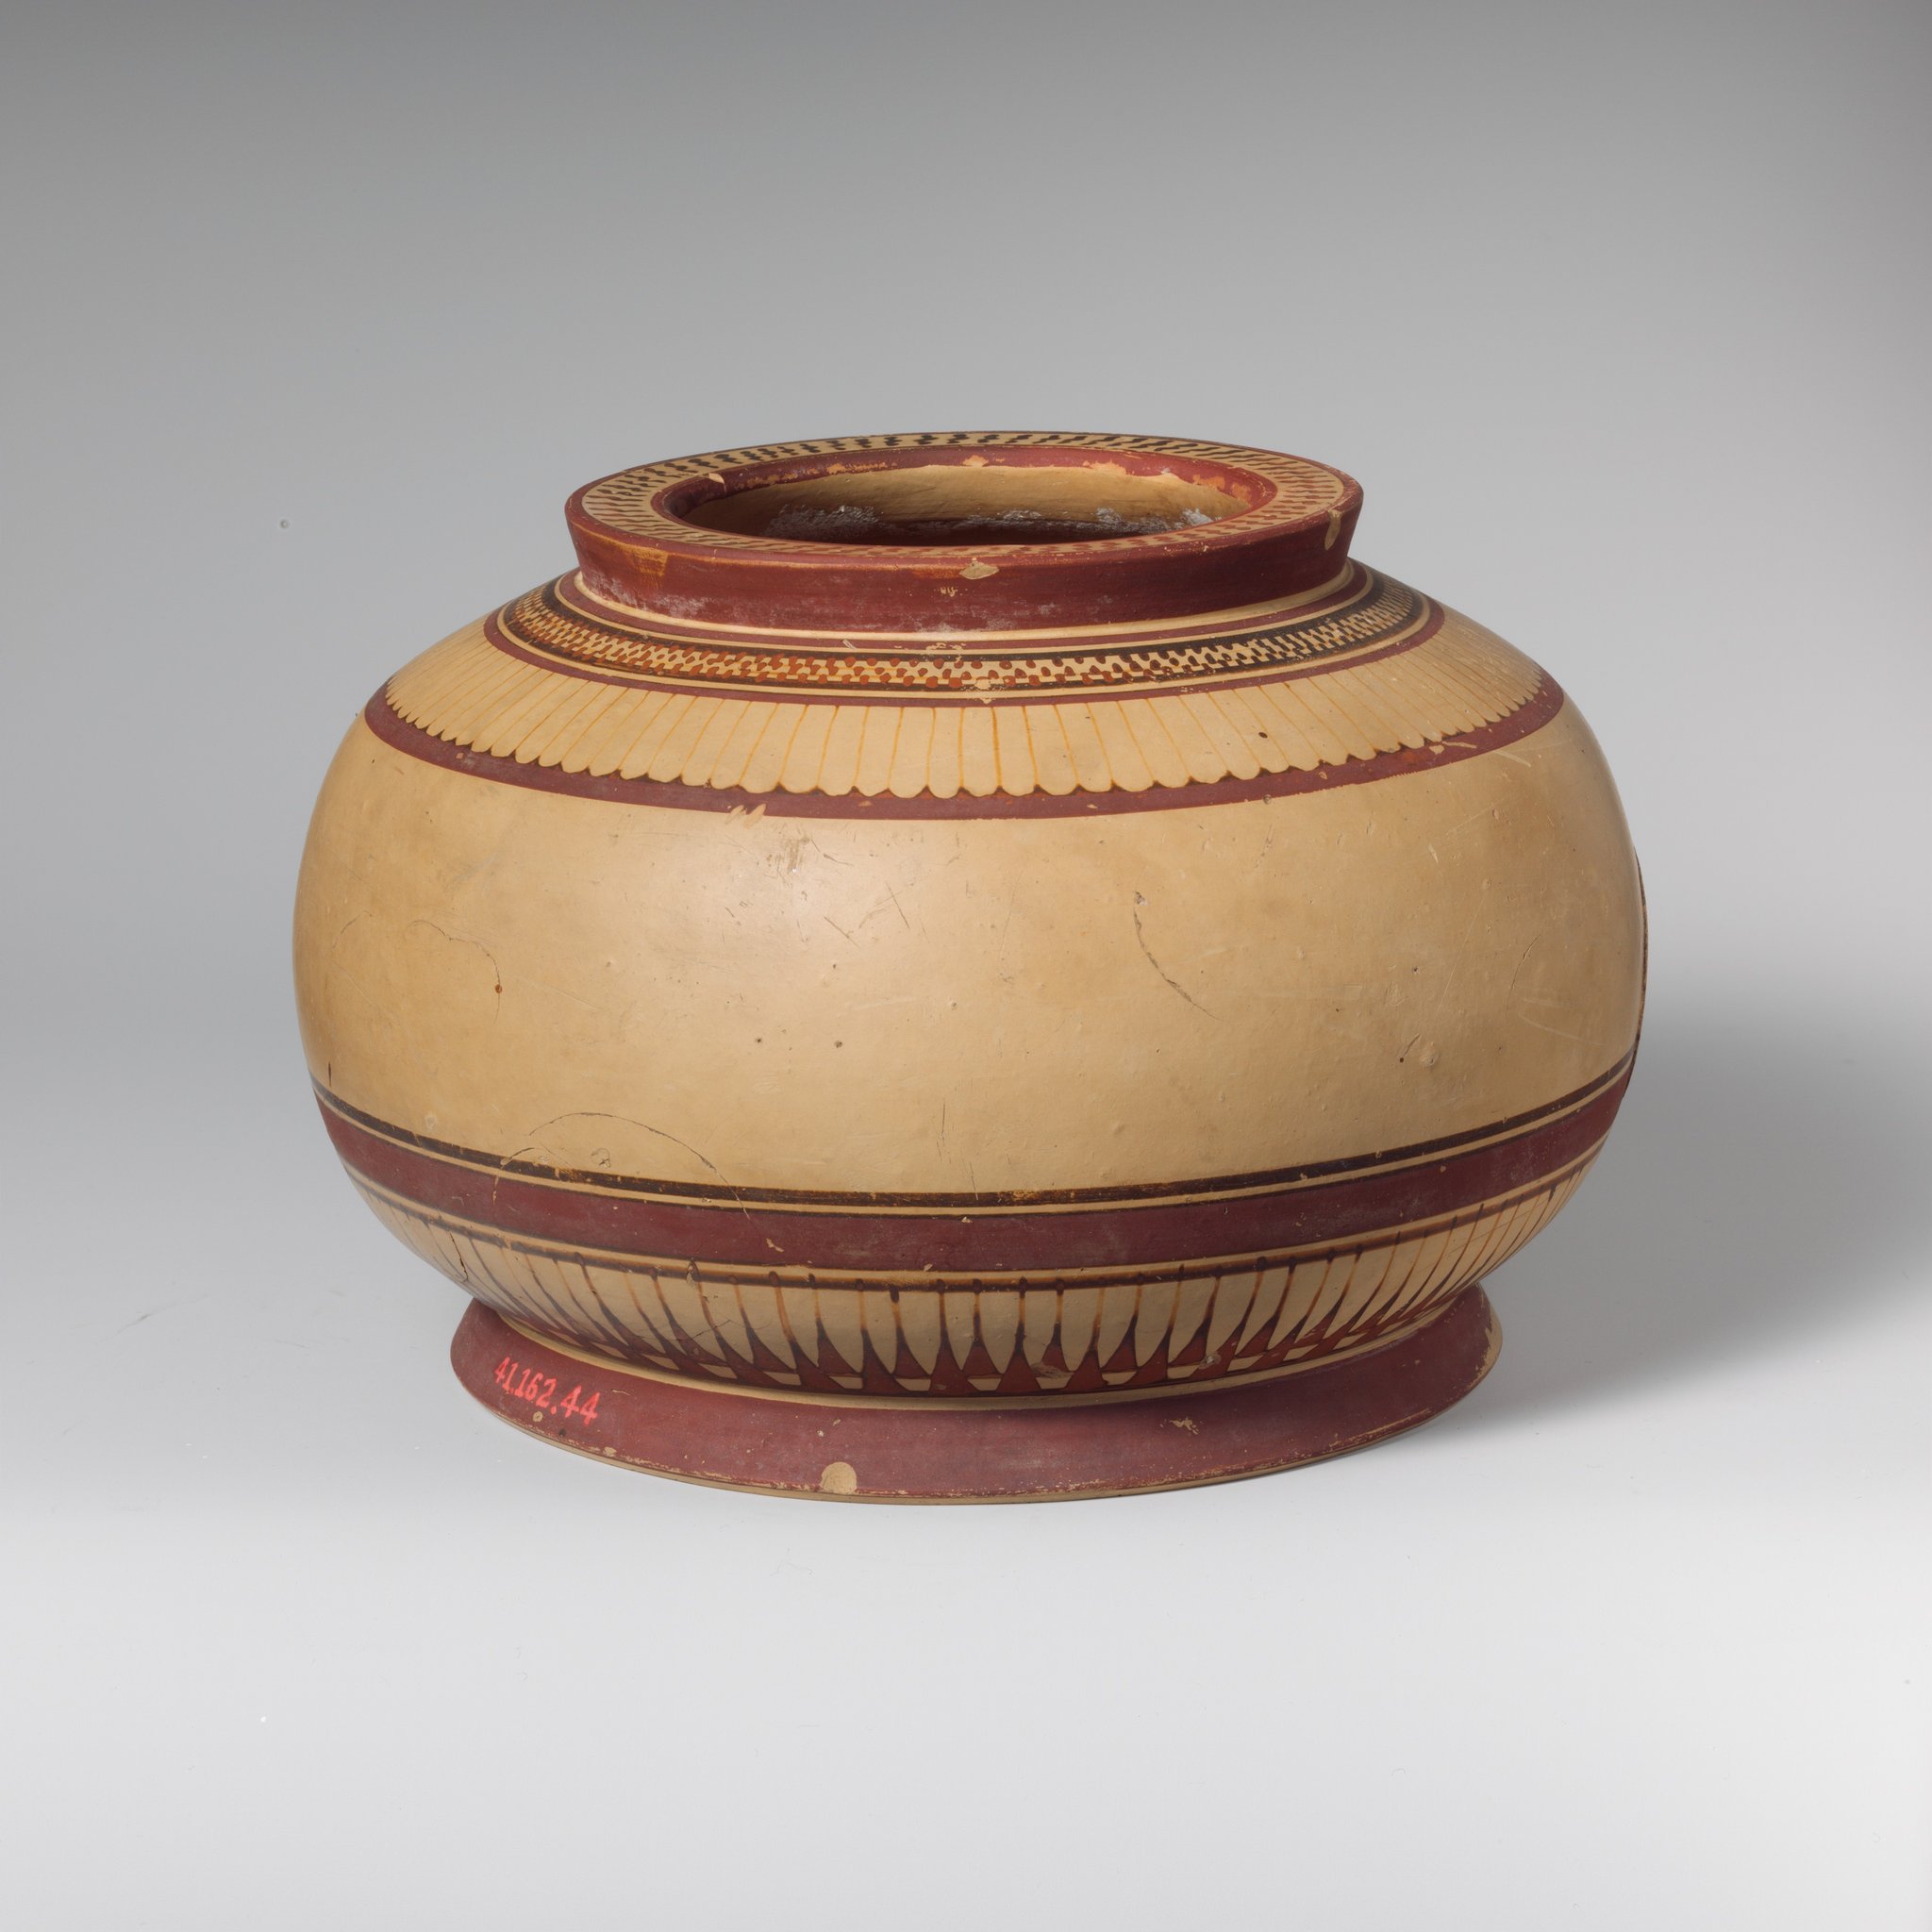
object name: pyxis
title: Terracotta pyxis (box)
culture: greek, corinthian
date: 575-550 BCE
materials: terracotta